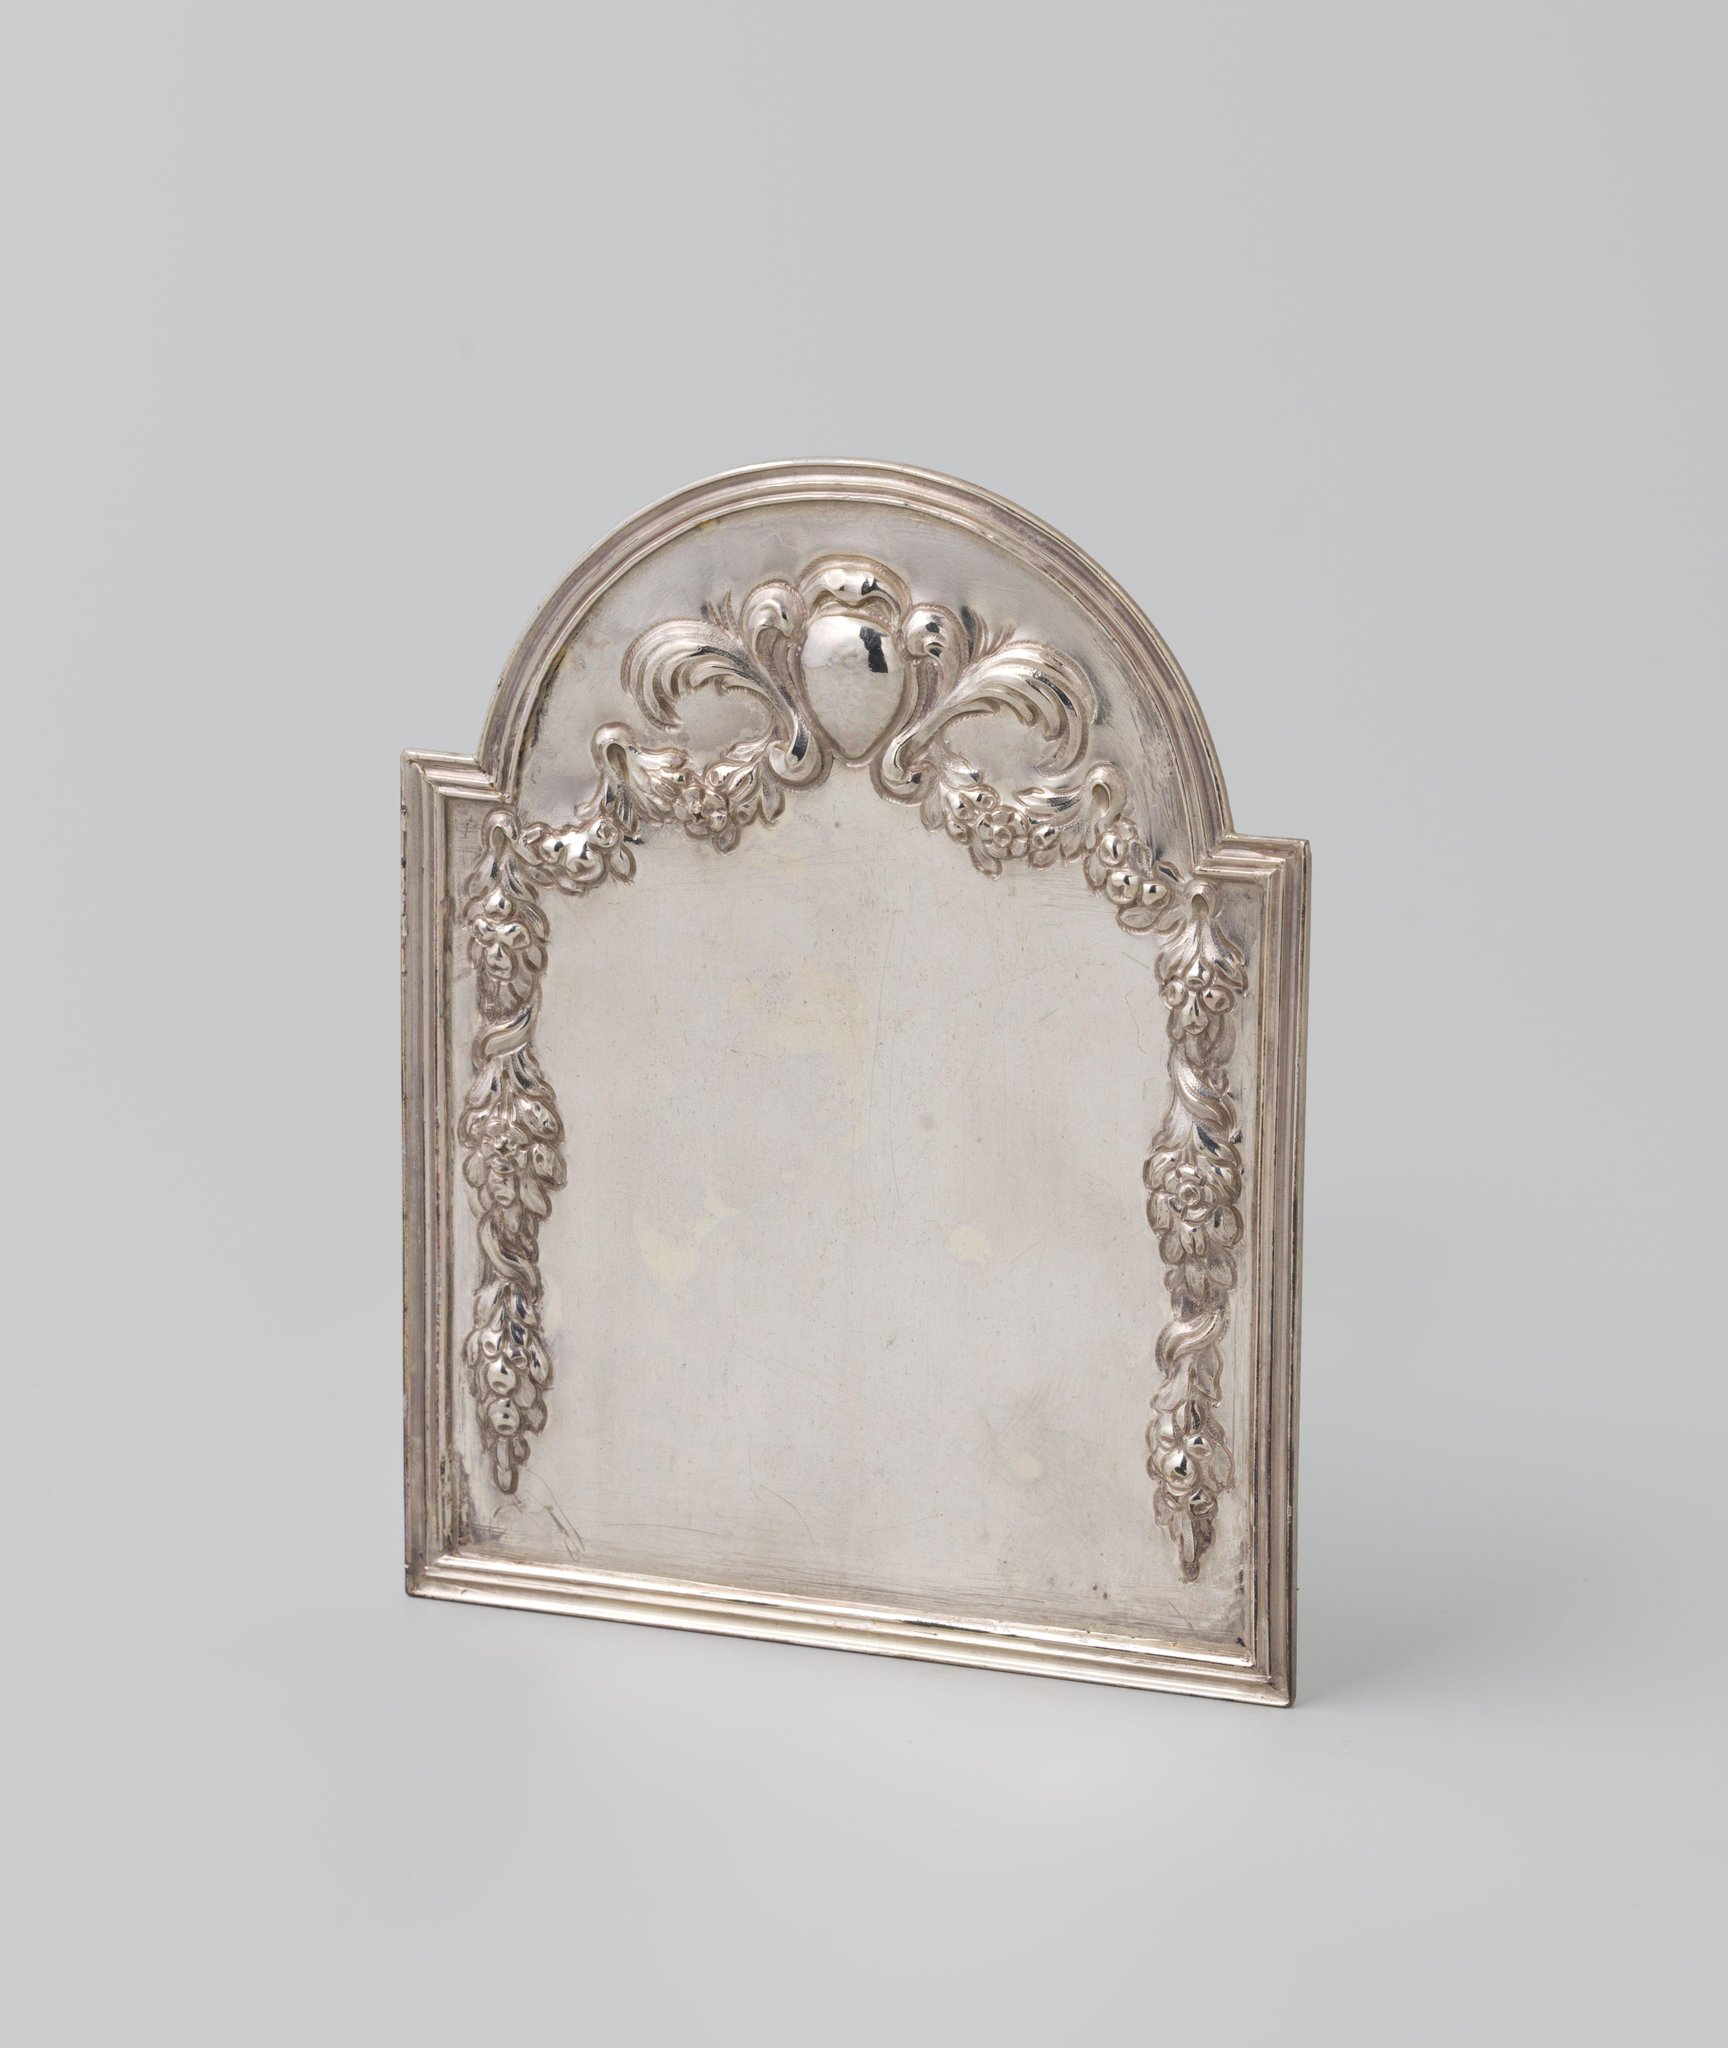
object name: miniature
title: Zilveren haardplaat, vlakke plaat omlijst door profielrand en versierd met een glad schild, bladeren en hangende bloem- en vruchtguirlandes (drijfwerk).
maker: Anonymous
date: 1710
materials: silver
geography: amsterdam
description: Zilveren haardplaat, vlakke plaat omlijst door profielrand en versierd met een glad schild, bladeren en hangende bloemen- en vruchtguirlandes (drijfwerk).